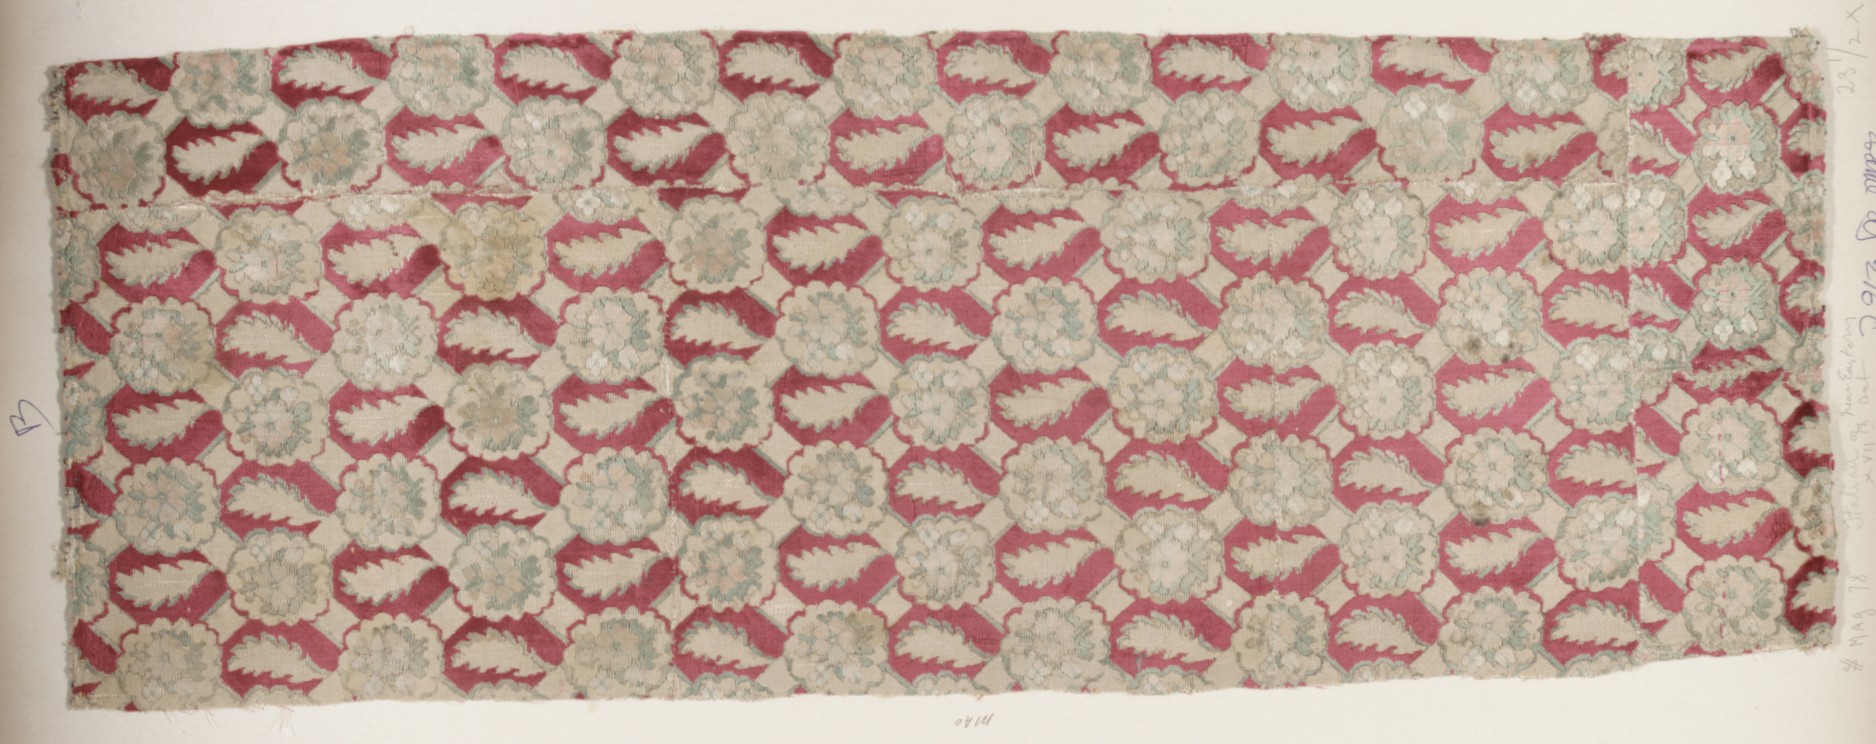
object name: fragment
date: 1701-1800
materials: metal thread, silk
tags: flowers,leaves